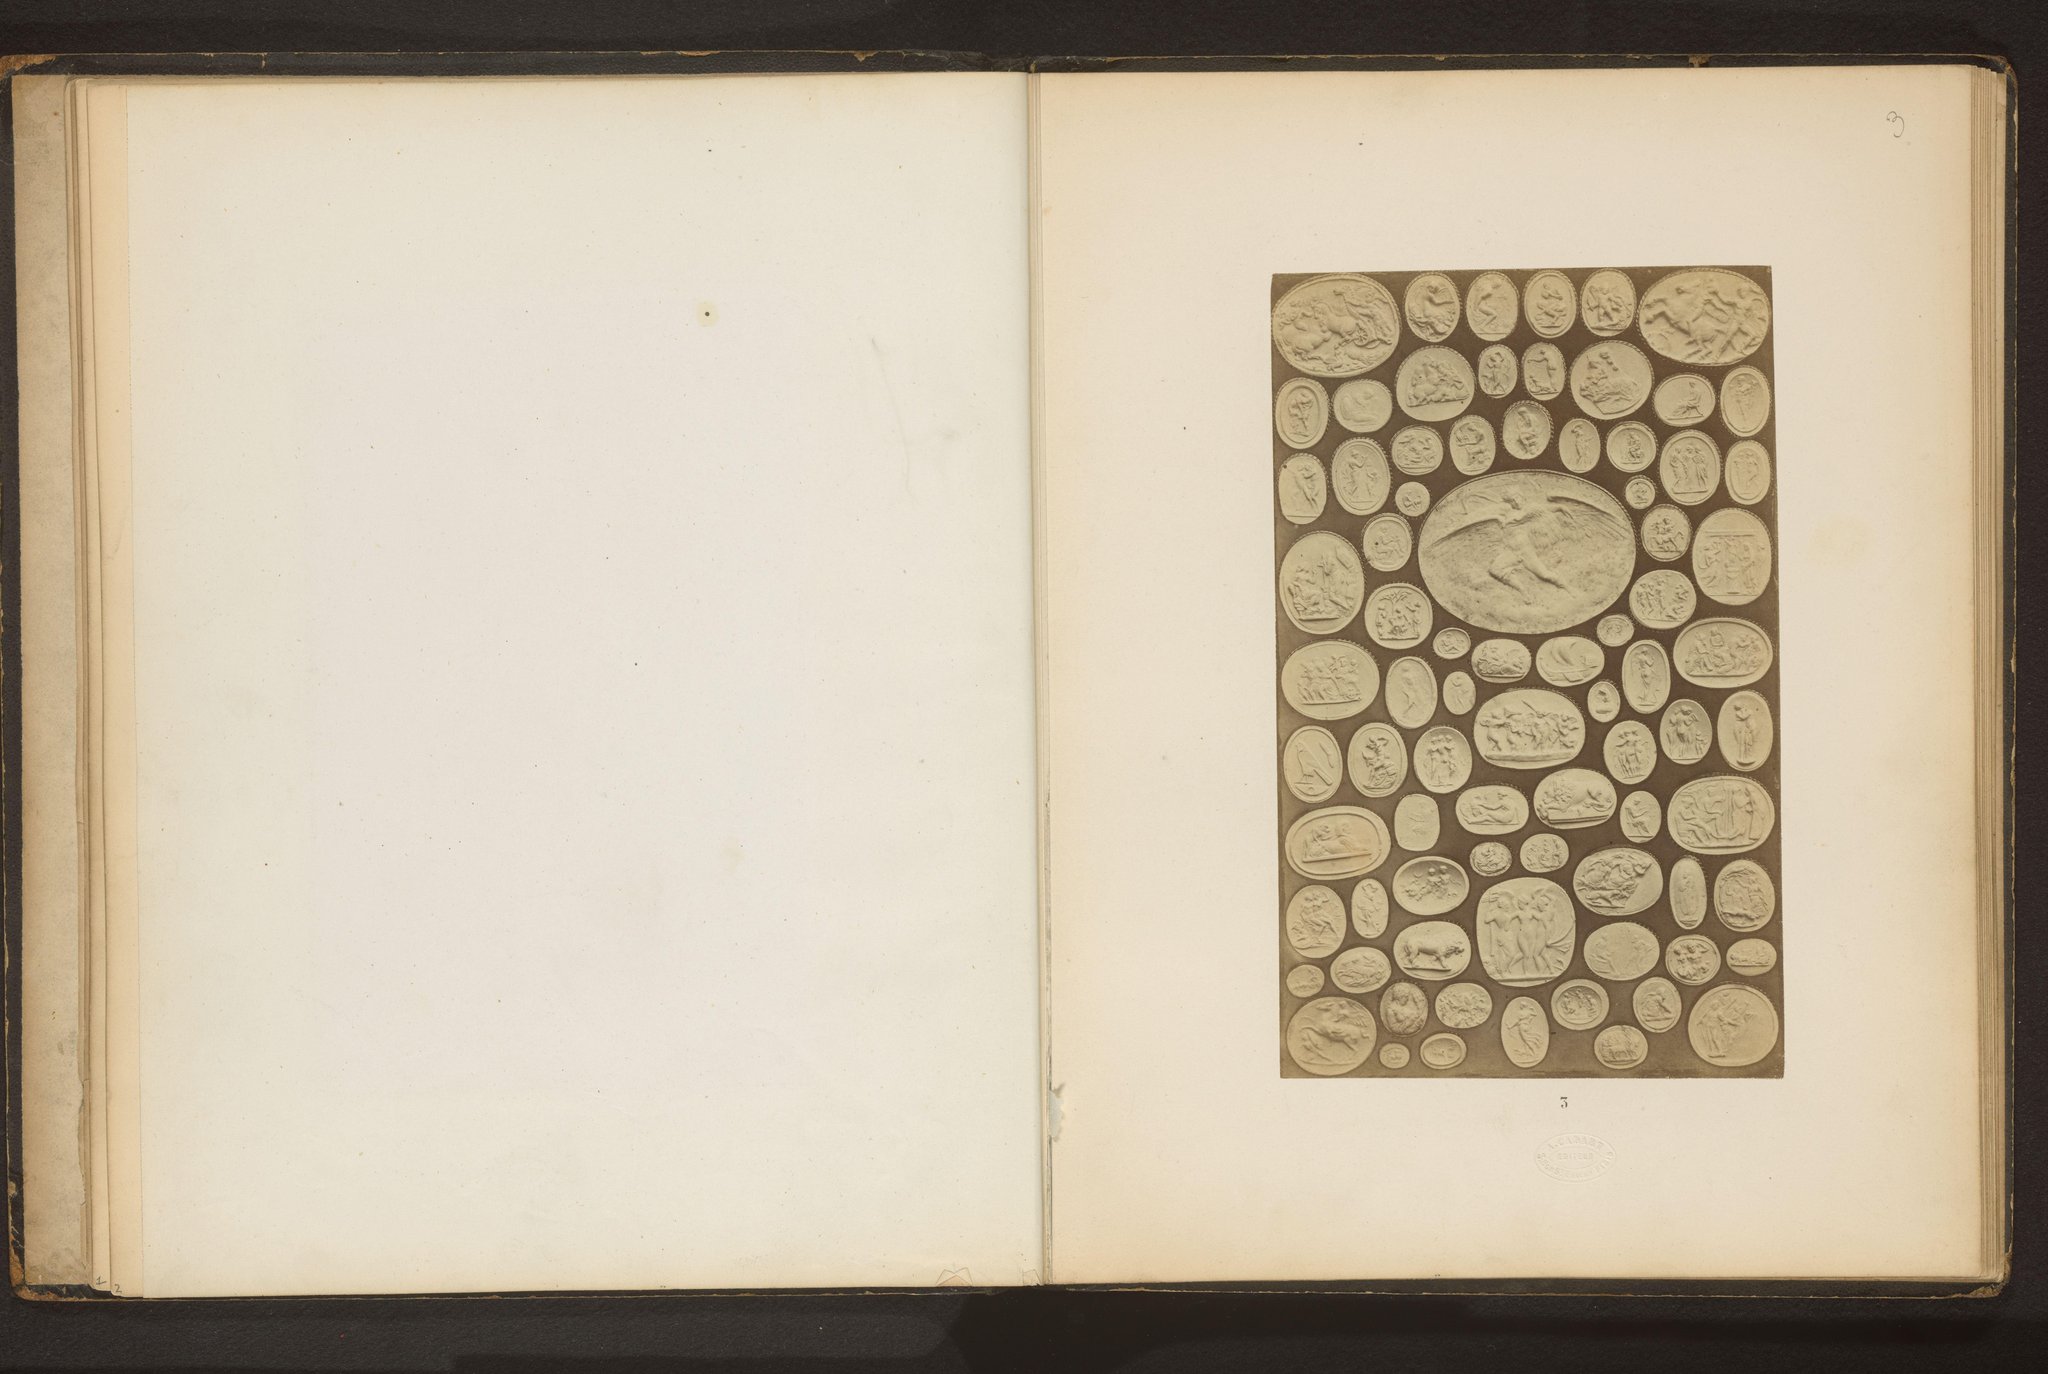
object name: page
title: Antieke medailles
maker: Anonymous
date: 1849-1859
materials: photographic support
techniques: albumen print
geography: rome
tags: medal (considered as a piece of sculpture, regardless of its specific function)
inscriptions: number: ‘3’, name: ‘A. Cadart 3. Rue St. Fiacre Paris Editeur’